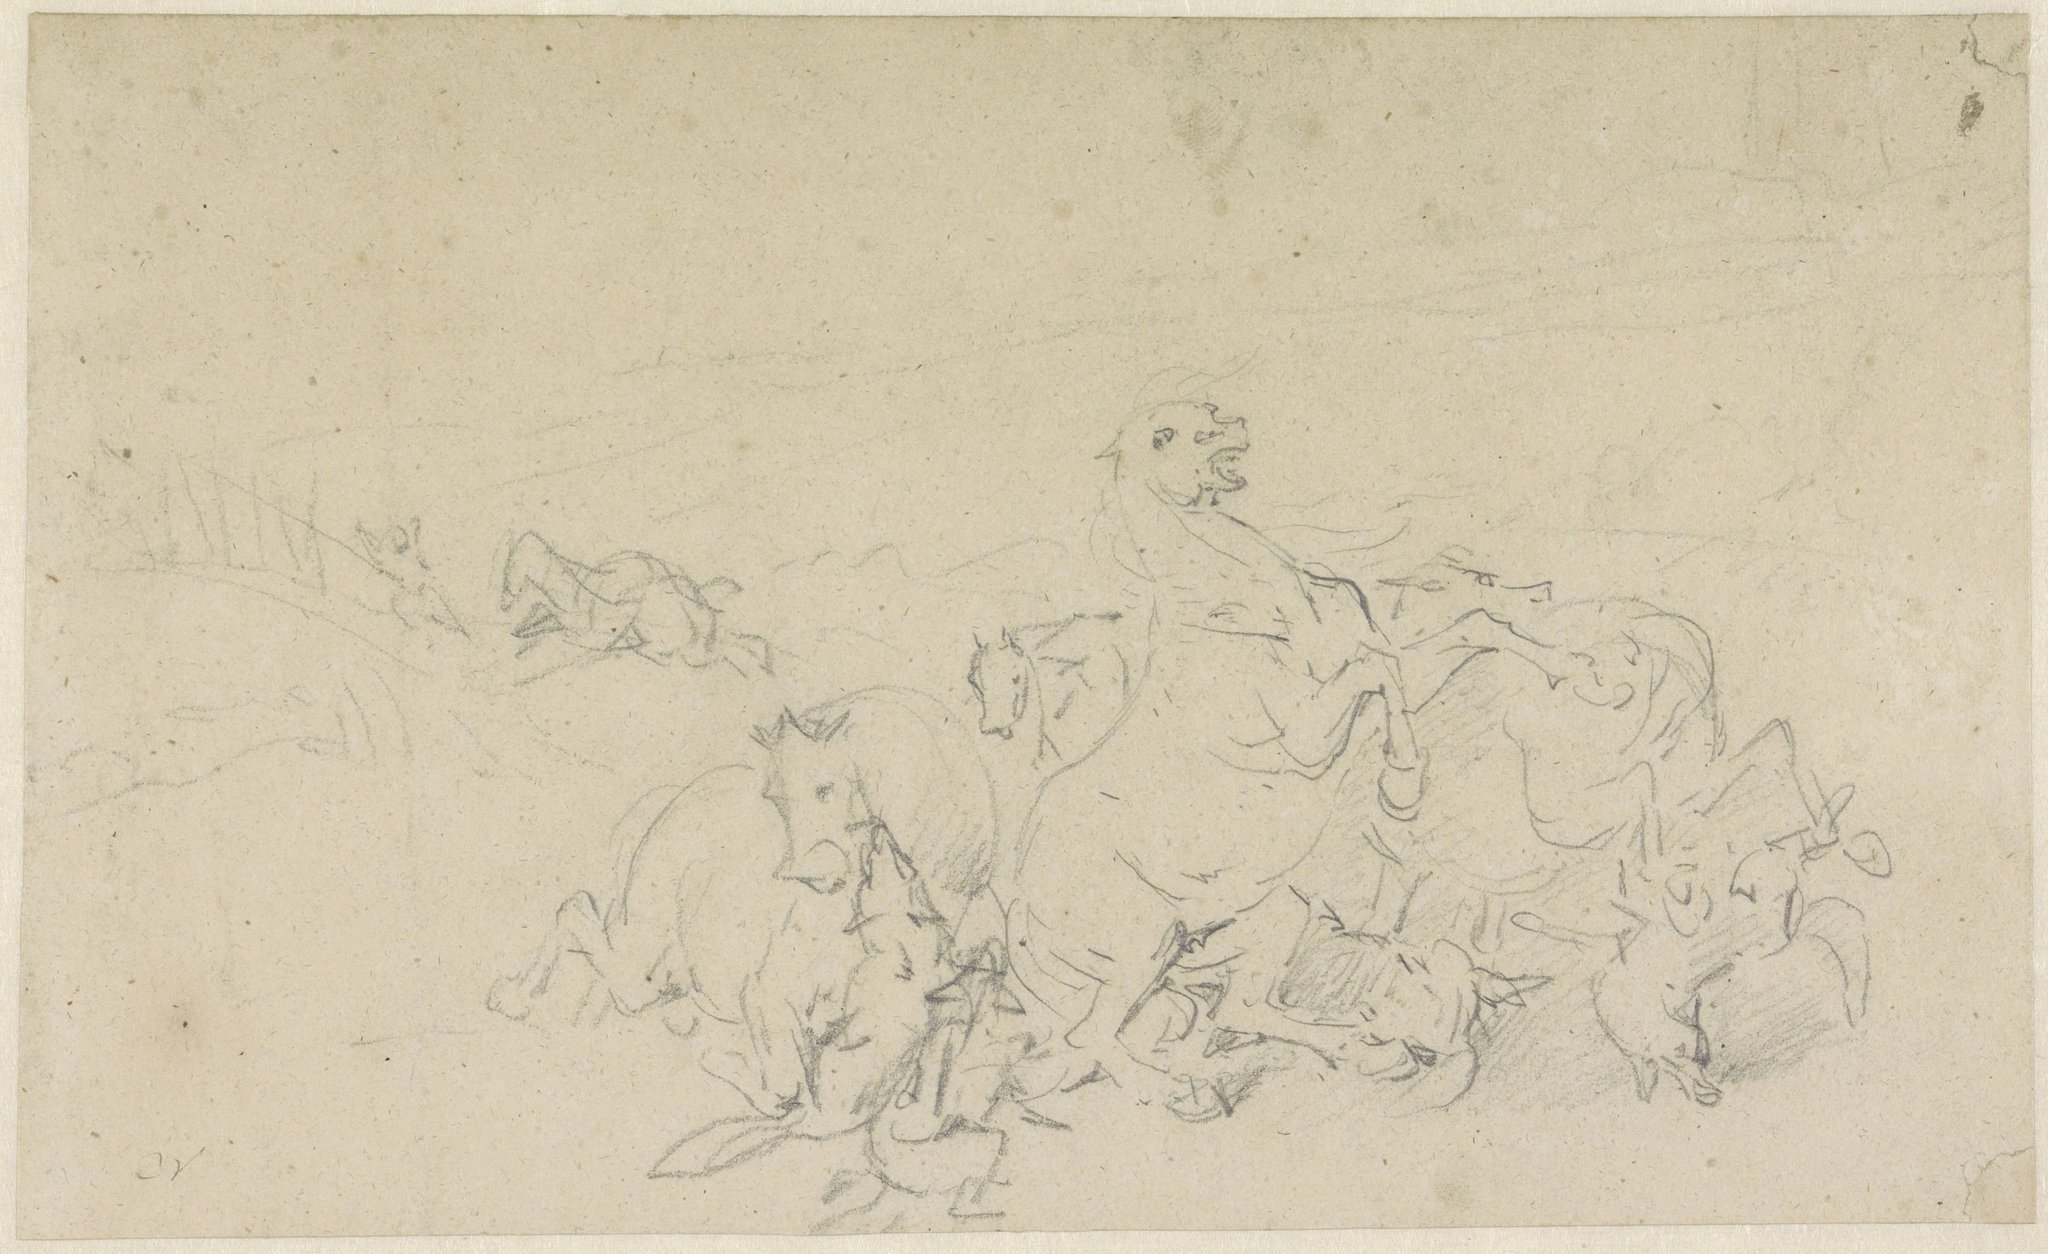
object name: drawing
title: Hongerige wolven overvallen een groep ruiters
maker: eugène verboeckhoven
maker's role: draughtsman, painter, print maker, printer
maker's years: 1798-1881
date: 1826-1836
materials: paper, pencil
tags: beasts of prey, predatory animals: wolf (+ herd, group of animals)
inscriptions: monogram: ‘EV’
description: Voorstudie voor een schilderij, gedateerd 1836, eveneens aanwezig in het Rijksmuseum.